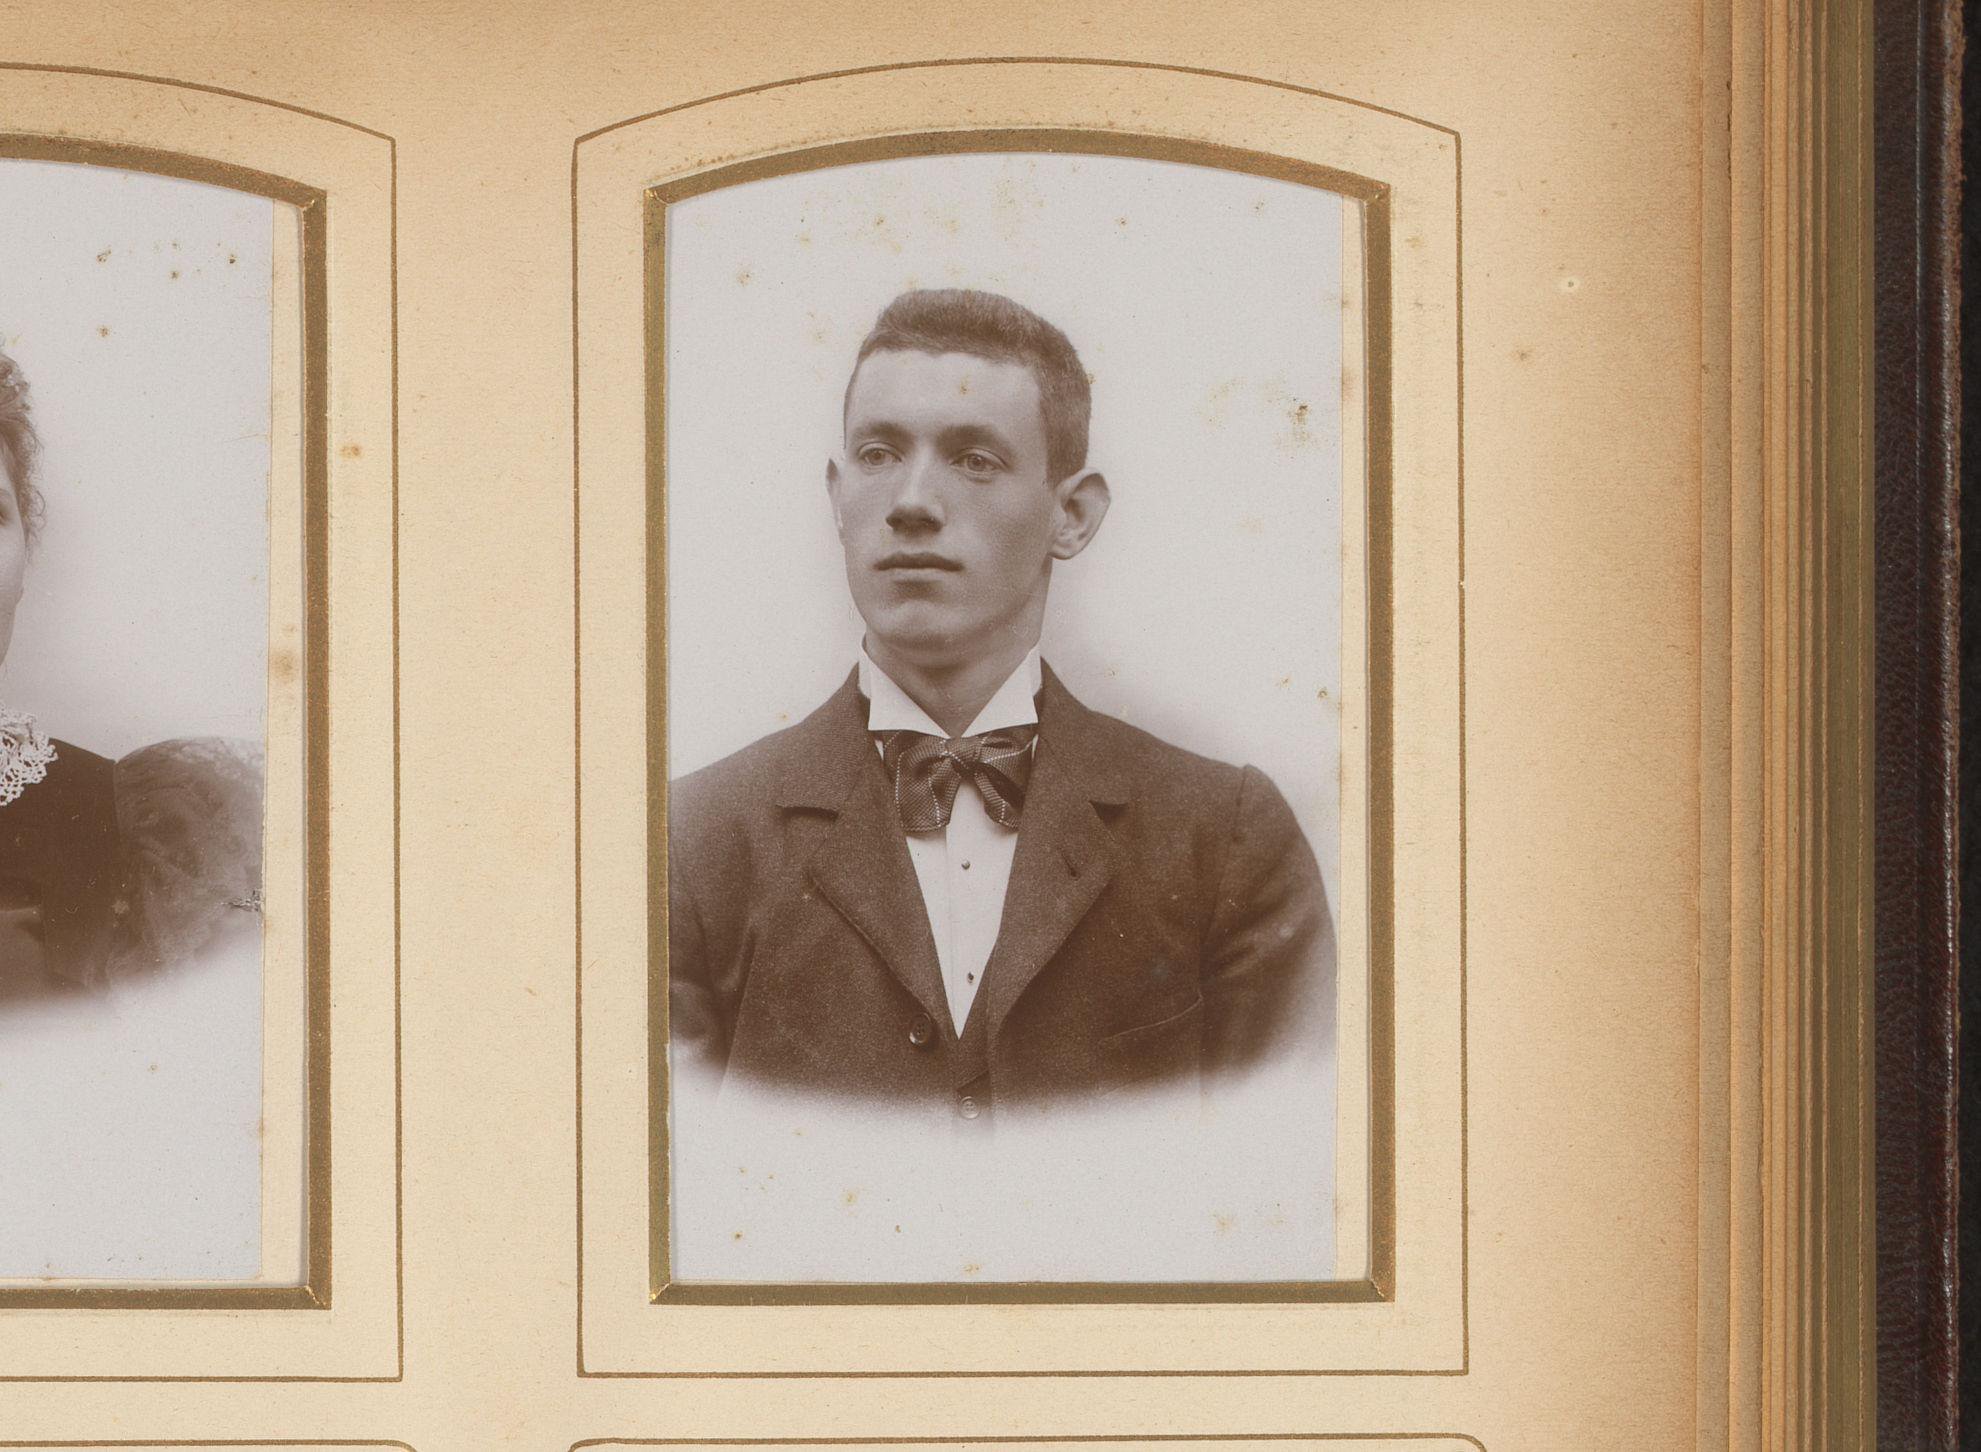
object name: photograph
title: Portret van een jonge man met vlinderstrik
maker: jan frederik rienks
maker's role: fotograaf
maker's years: 1857-1909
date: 1880-1900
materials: cardboard, photographic support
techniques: collodion silver print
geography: leiden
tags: historical persons, youth, adolescent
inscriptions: inscription: ‘F. Rienks/ Photograaf/ Hoogewoerd 165/ Leiden./ Vergroottingen tot levensgroot naar/ elke Photographie./ De plaat blijft voor nabestelling bewaard.’